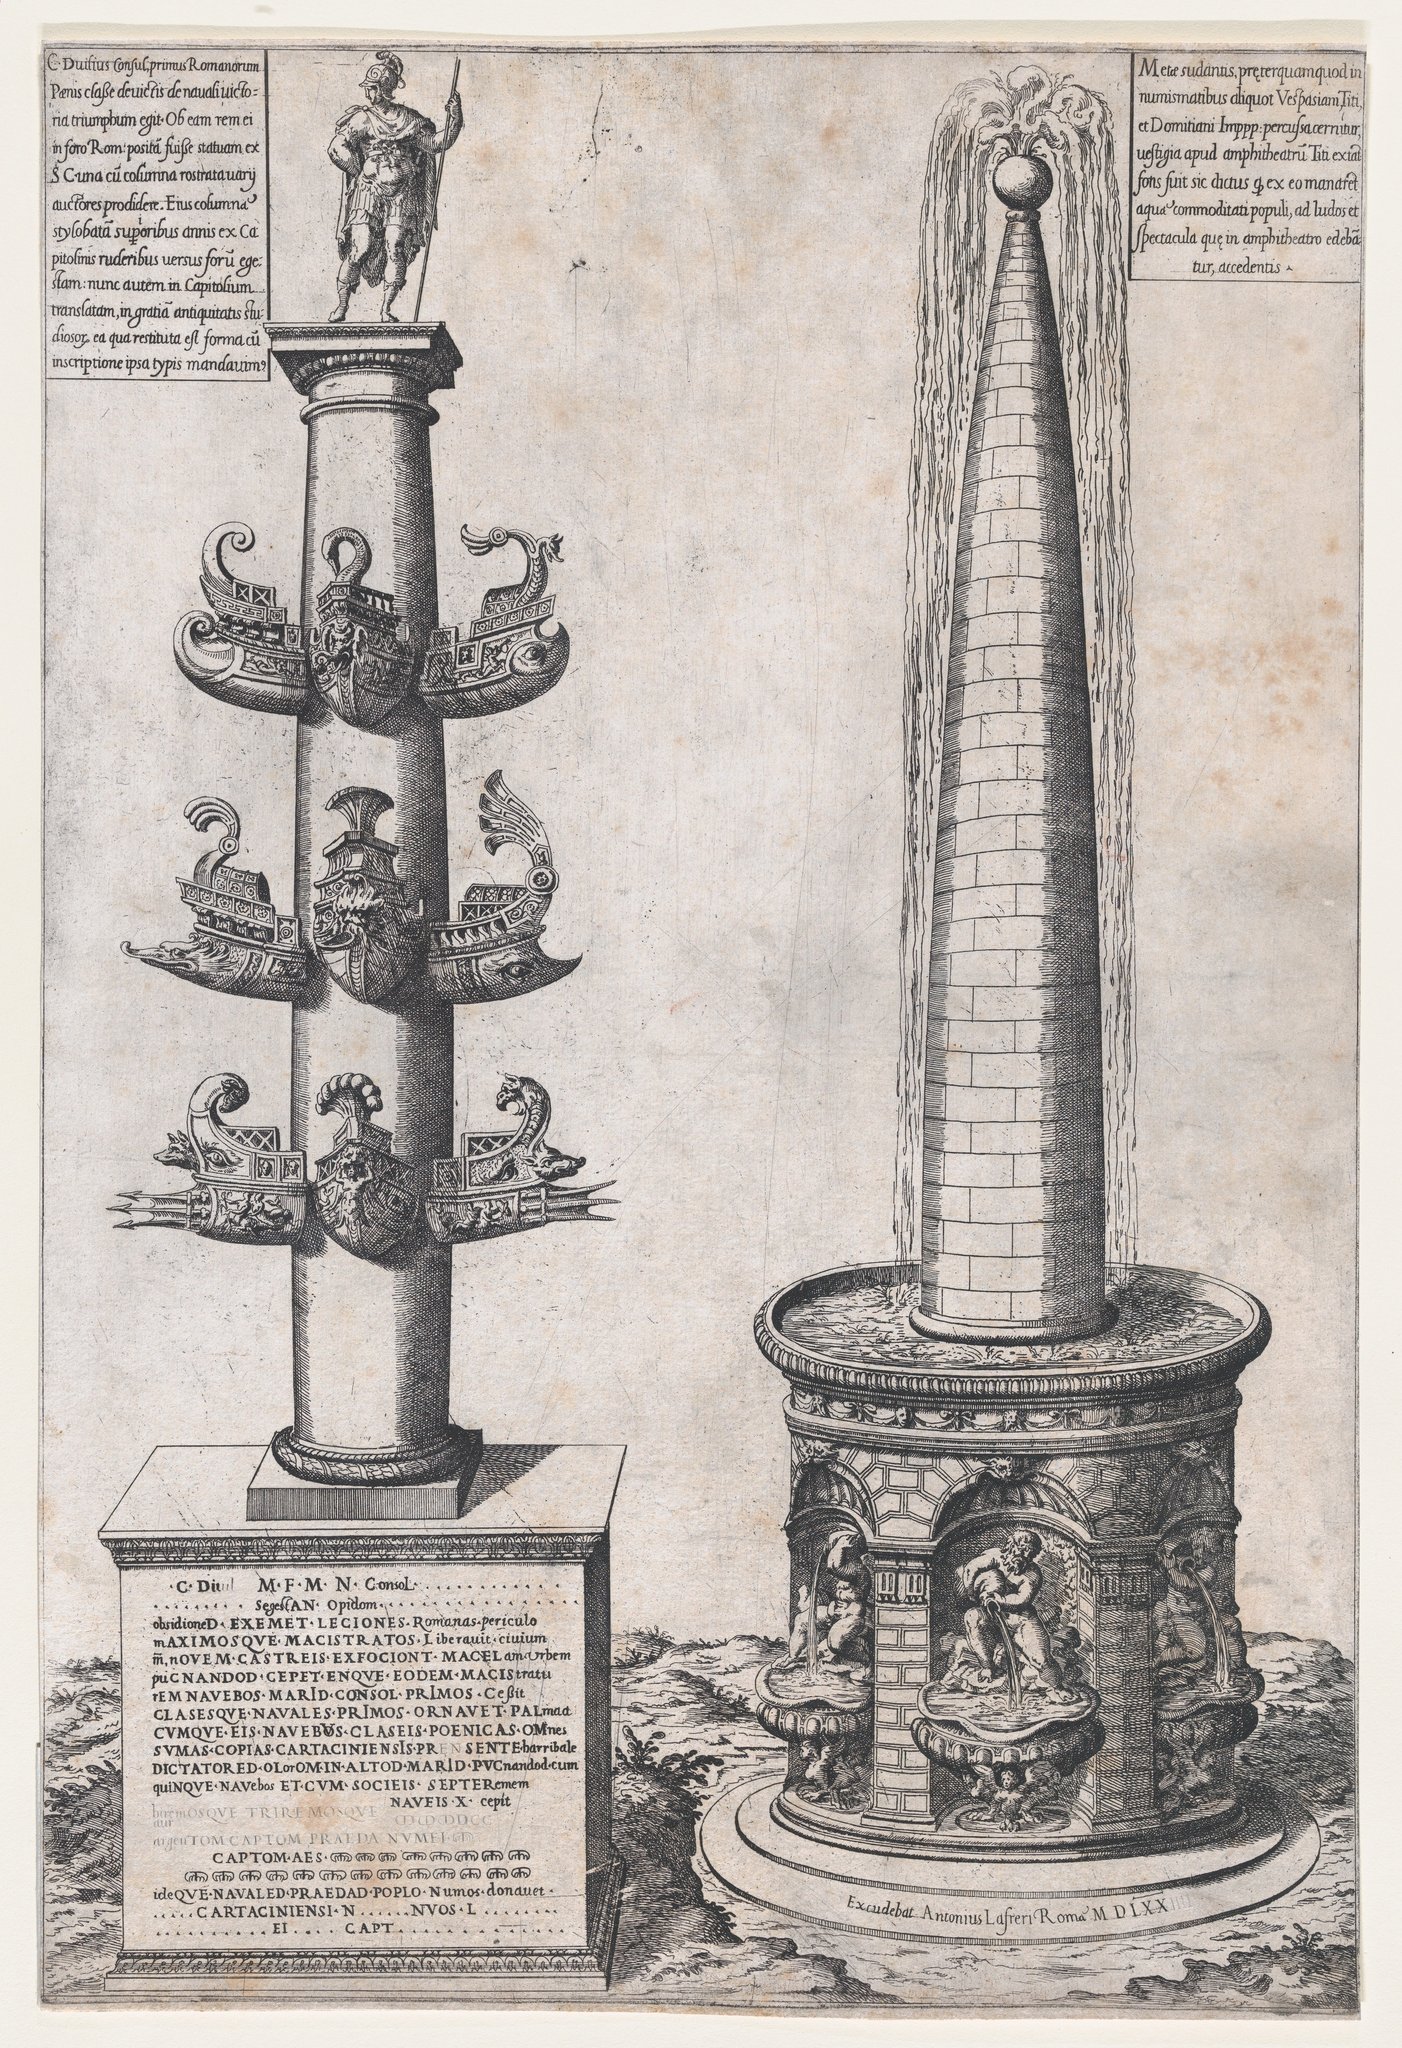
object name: print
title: Column of Dilius and Obelisque Fountain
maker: Anonymous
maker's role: artist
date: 1574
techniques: engraving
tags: columns,fountains,obelisks